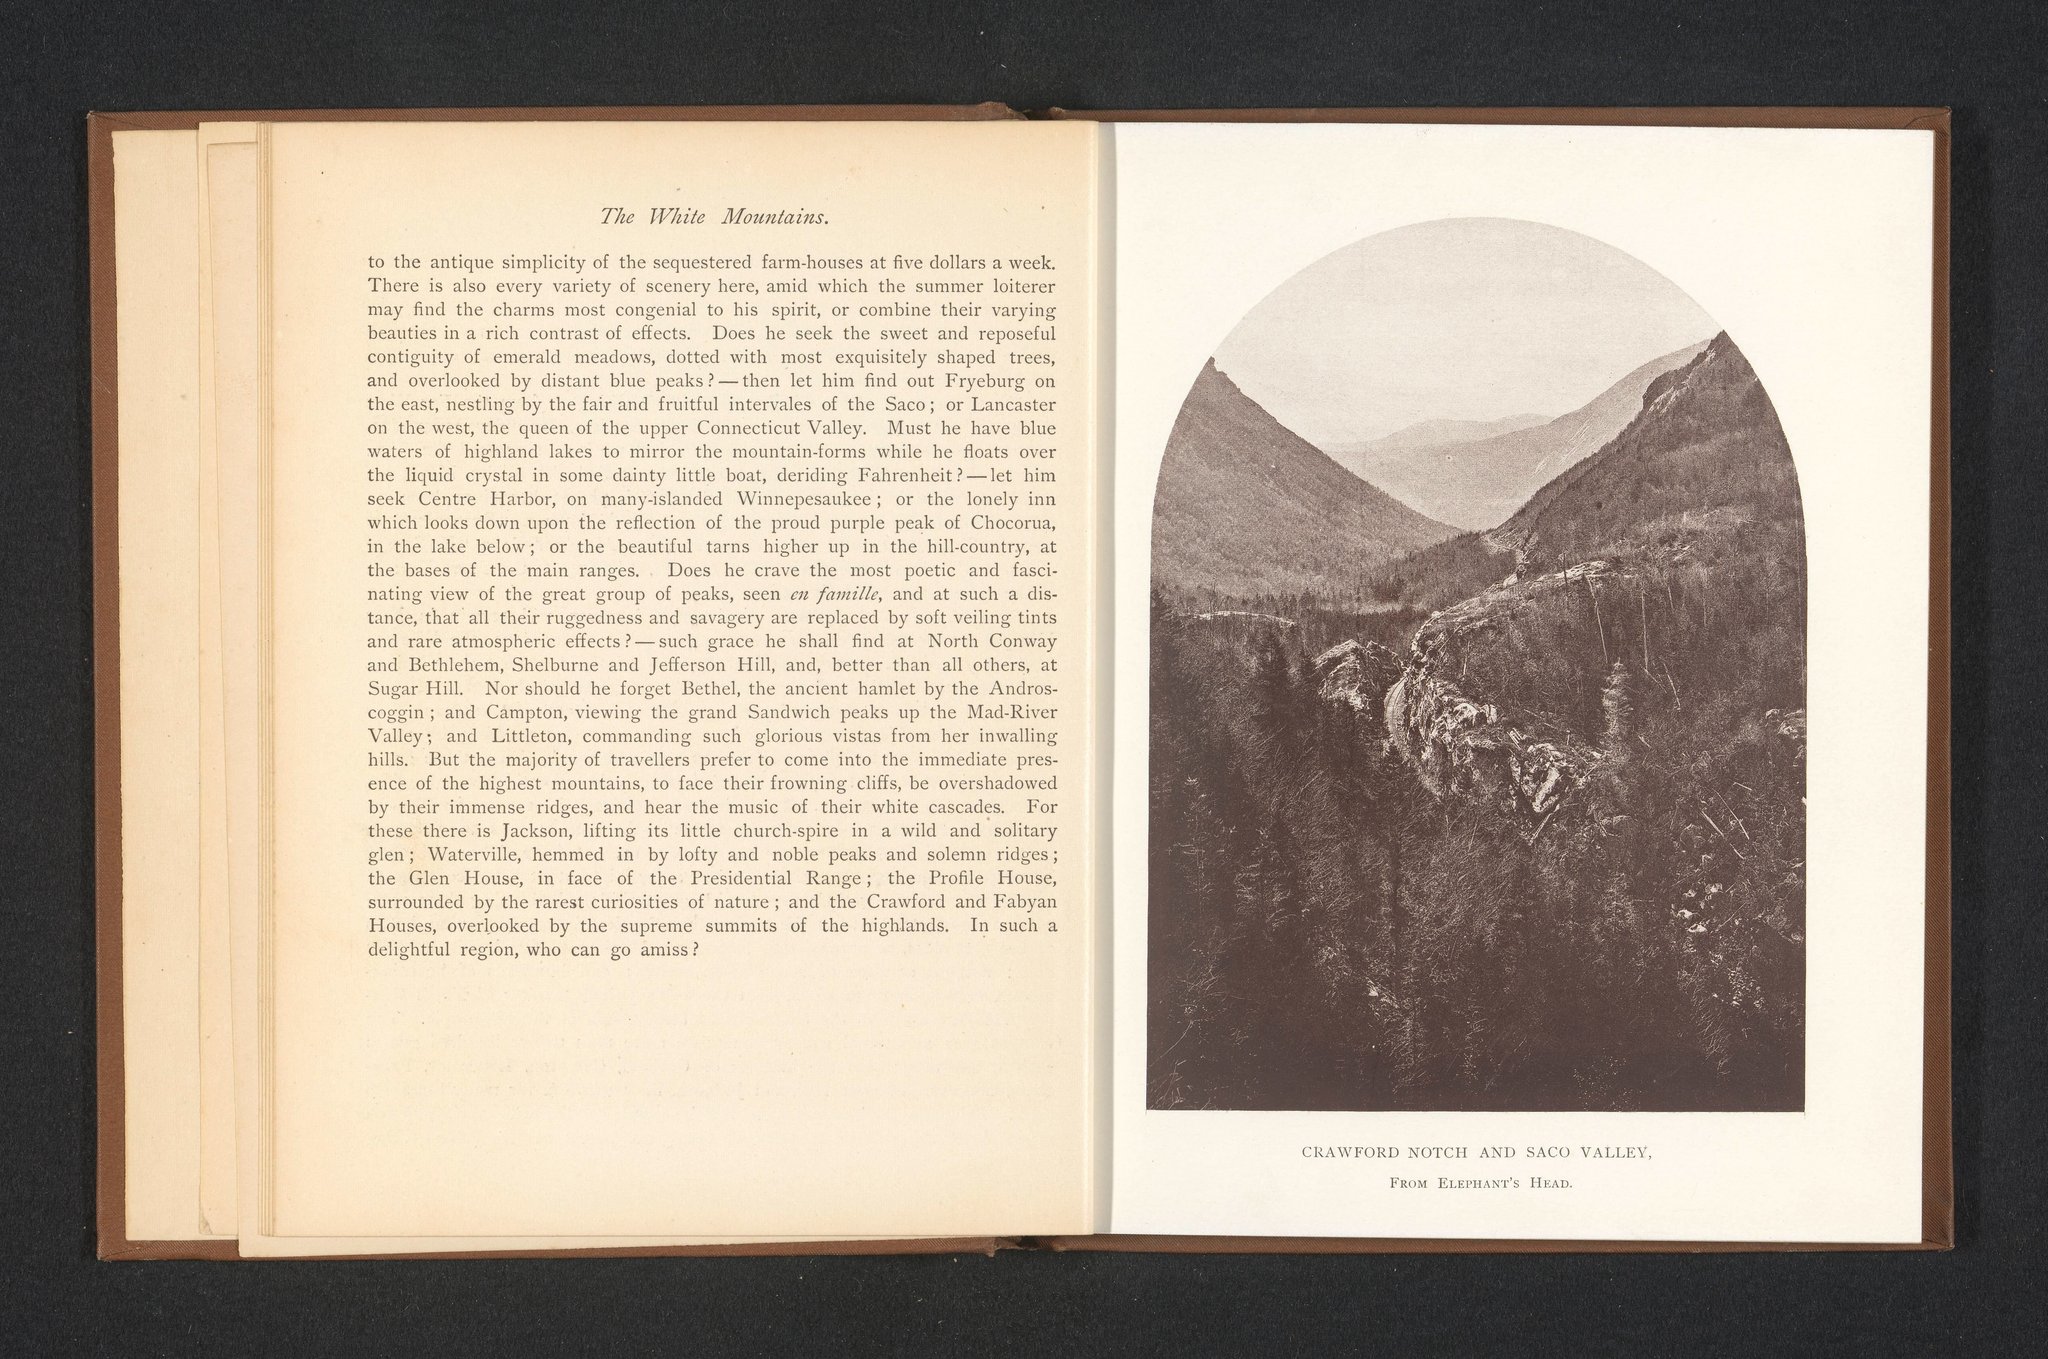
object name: photomechanical print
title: Crawford Notch and Saco Valley,/ From Elephant's Head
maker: Anonymous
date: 1874-1879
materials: paper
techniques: photograph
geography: white mountains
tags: dale, valley, mountains